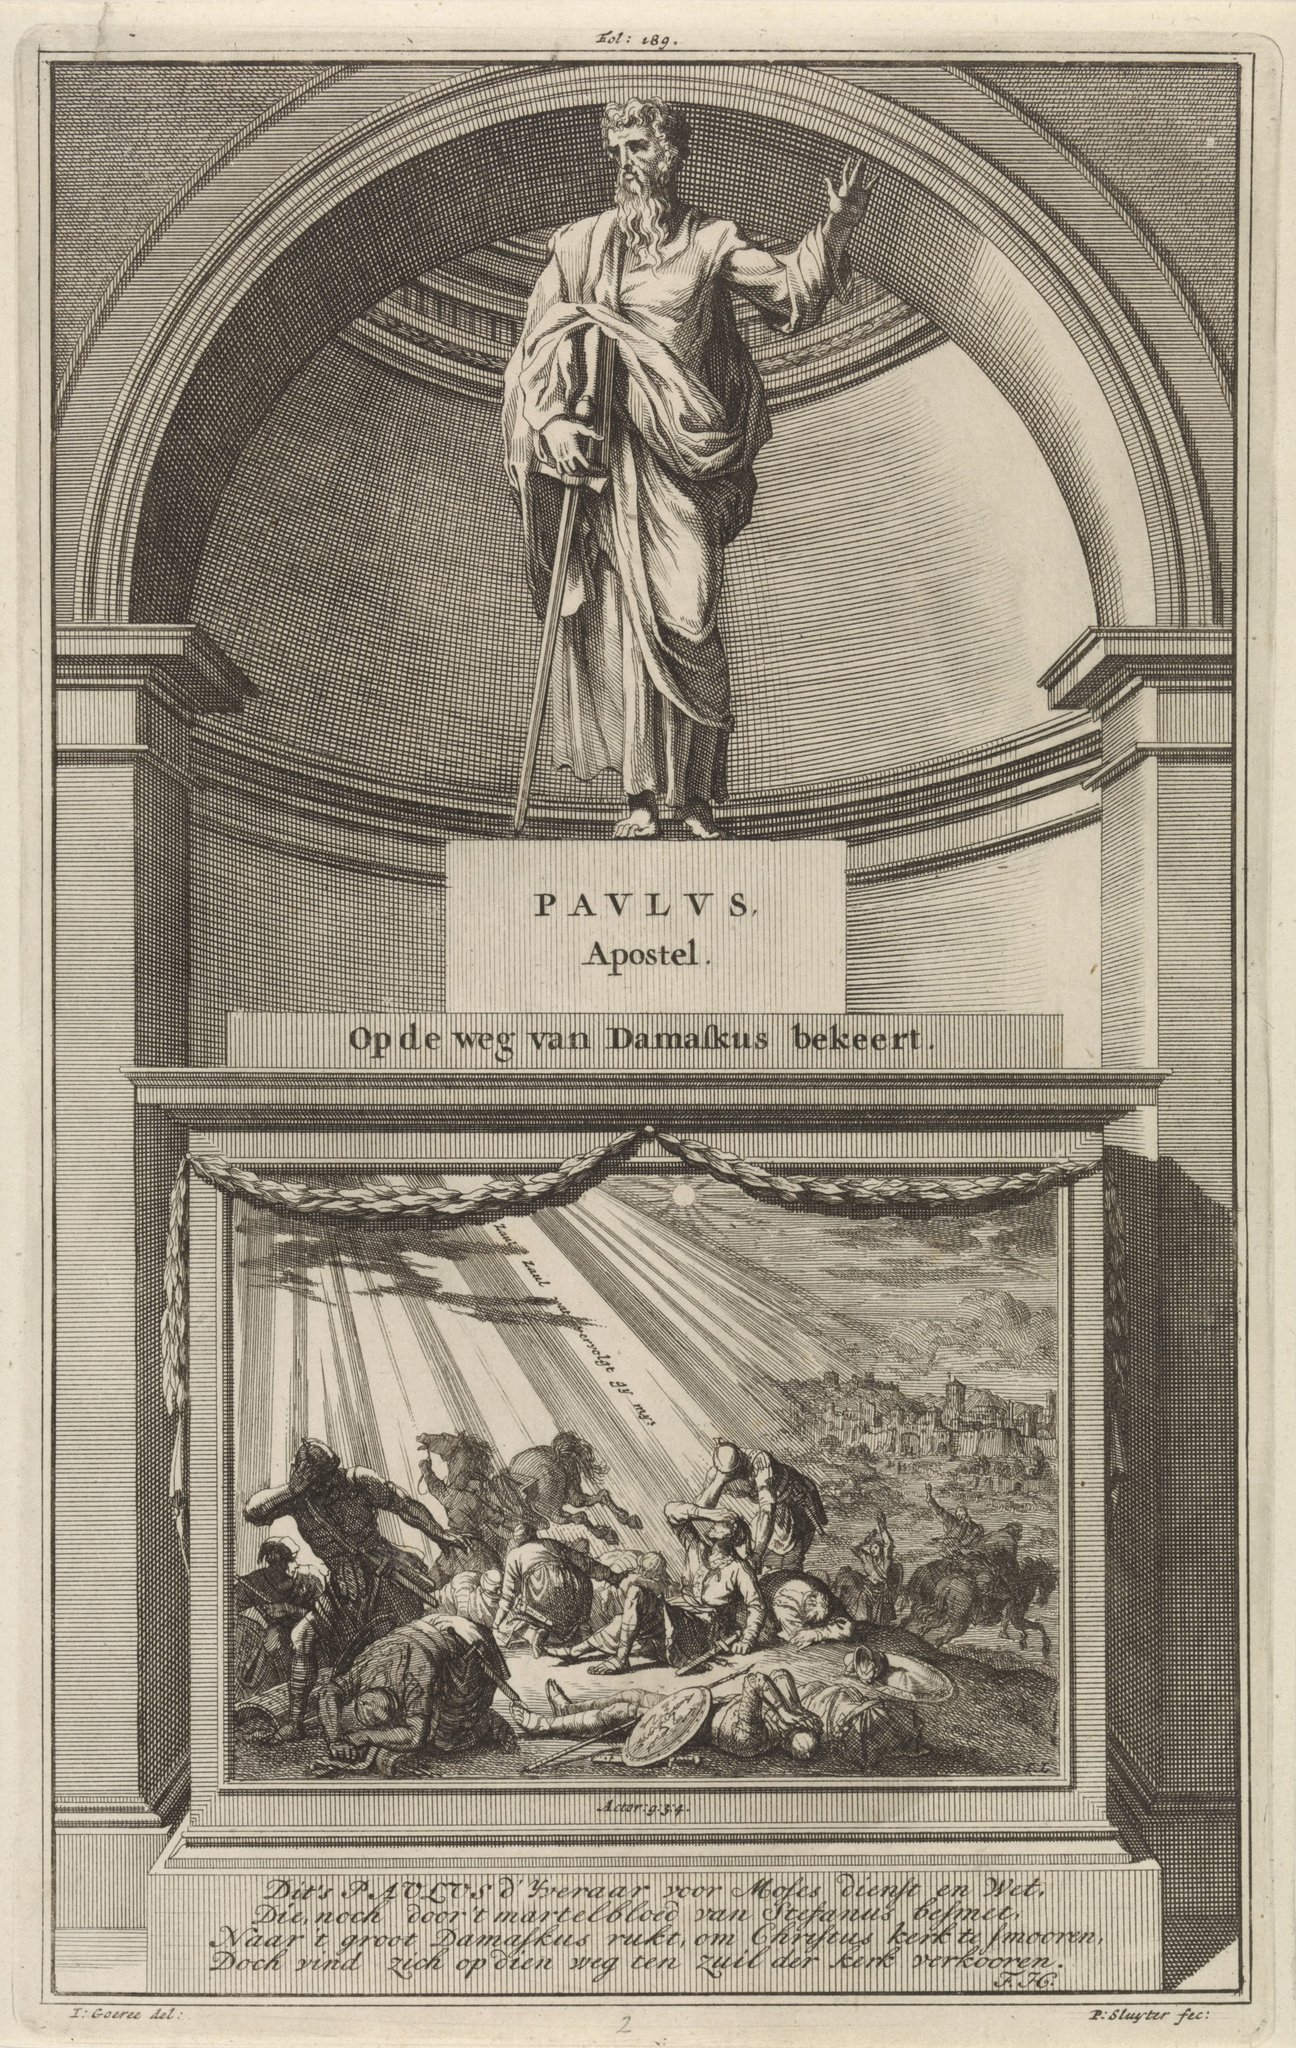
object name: book illustration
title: Apostel Paulus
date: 1698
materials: paper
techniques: engraving, etching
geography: amsterdam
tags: on the way to damascus christ appears to saul, who falls from his horse and is blinded by the light, the apostle paul of tarsus; possible attributes: book, scroll, sword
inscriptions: number: ‘2’, collector's mark: Lugt 2228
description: De apostel Paulus met een zwaard in zijn hand. Paulus staat op een sokkel waar op de voorzijde zijn bekering tijdens de tocht naar Damascus in beeld is gebracht. Prent middenboven gemerkt: Fol: 189.